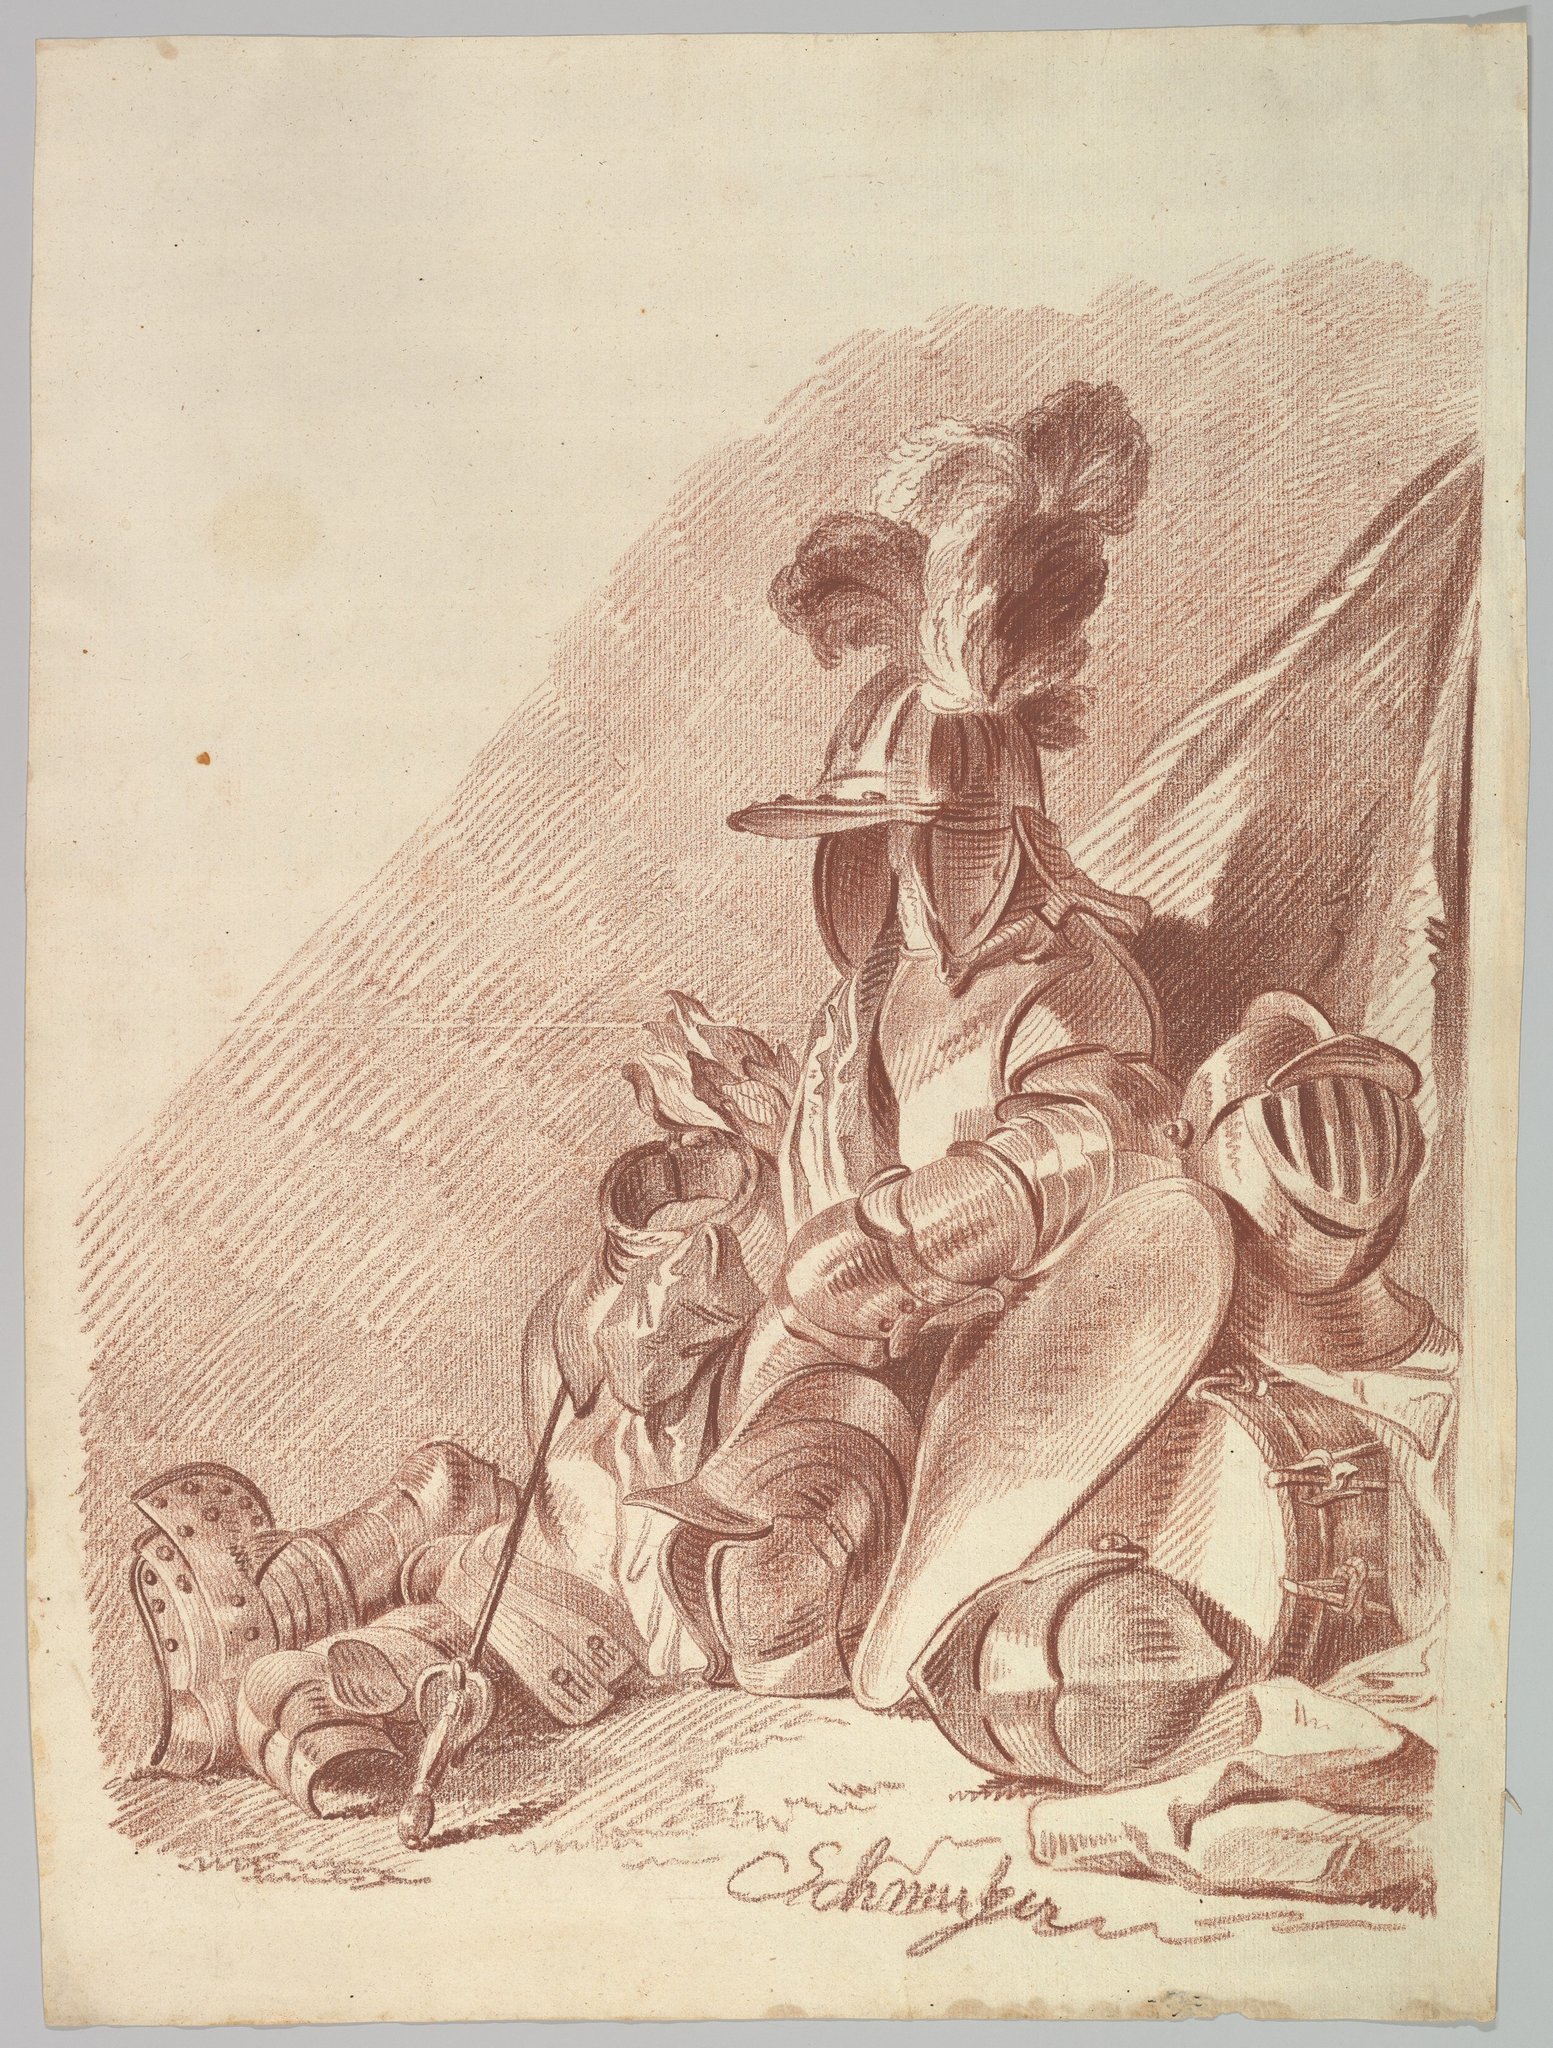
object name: drawing ornament architecture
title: Armorial Trophy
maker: jakob matthias schmutzer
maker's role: artist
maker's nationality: austrian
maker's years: 1733-1811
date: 1765-1810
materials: chalk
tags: armor,swords,drums,still life